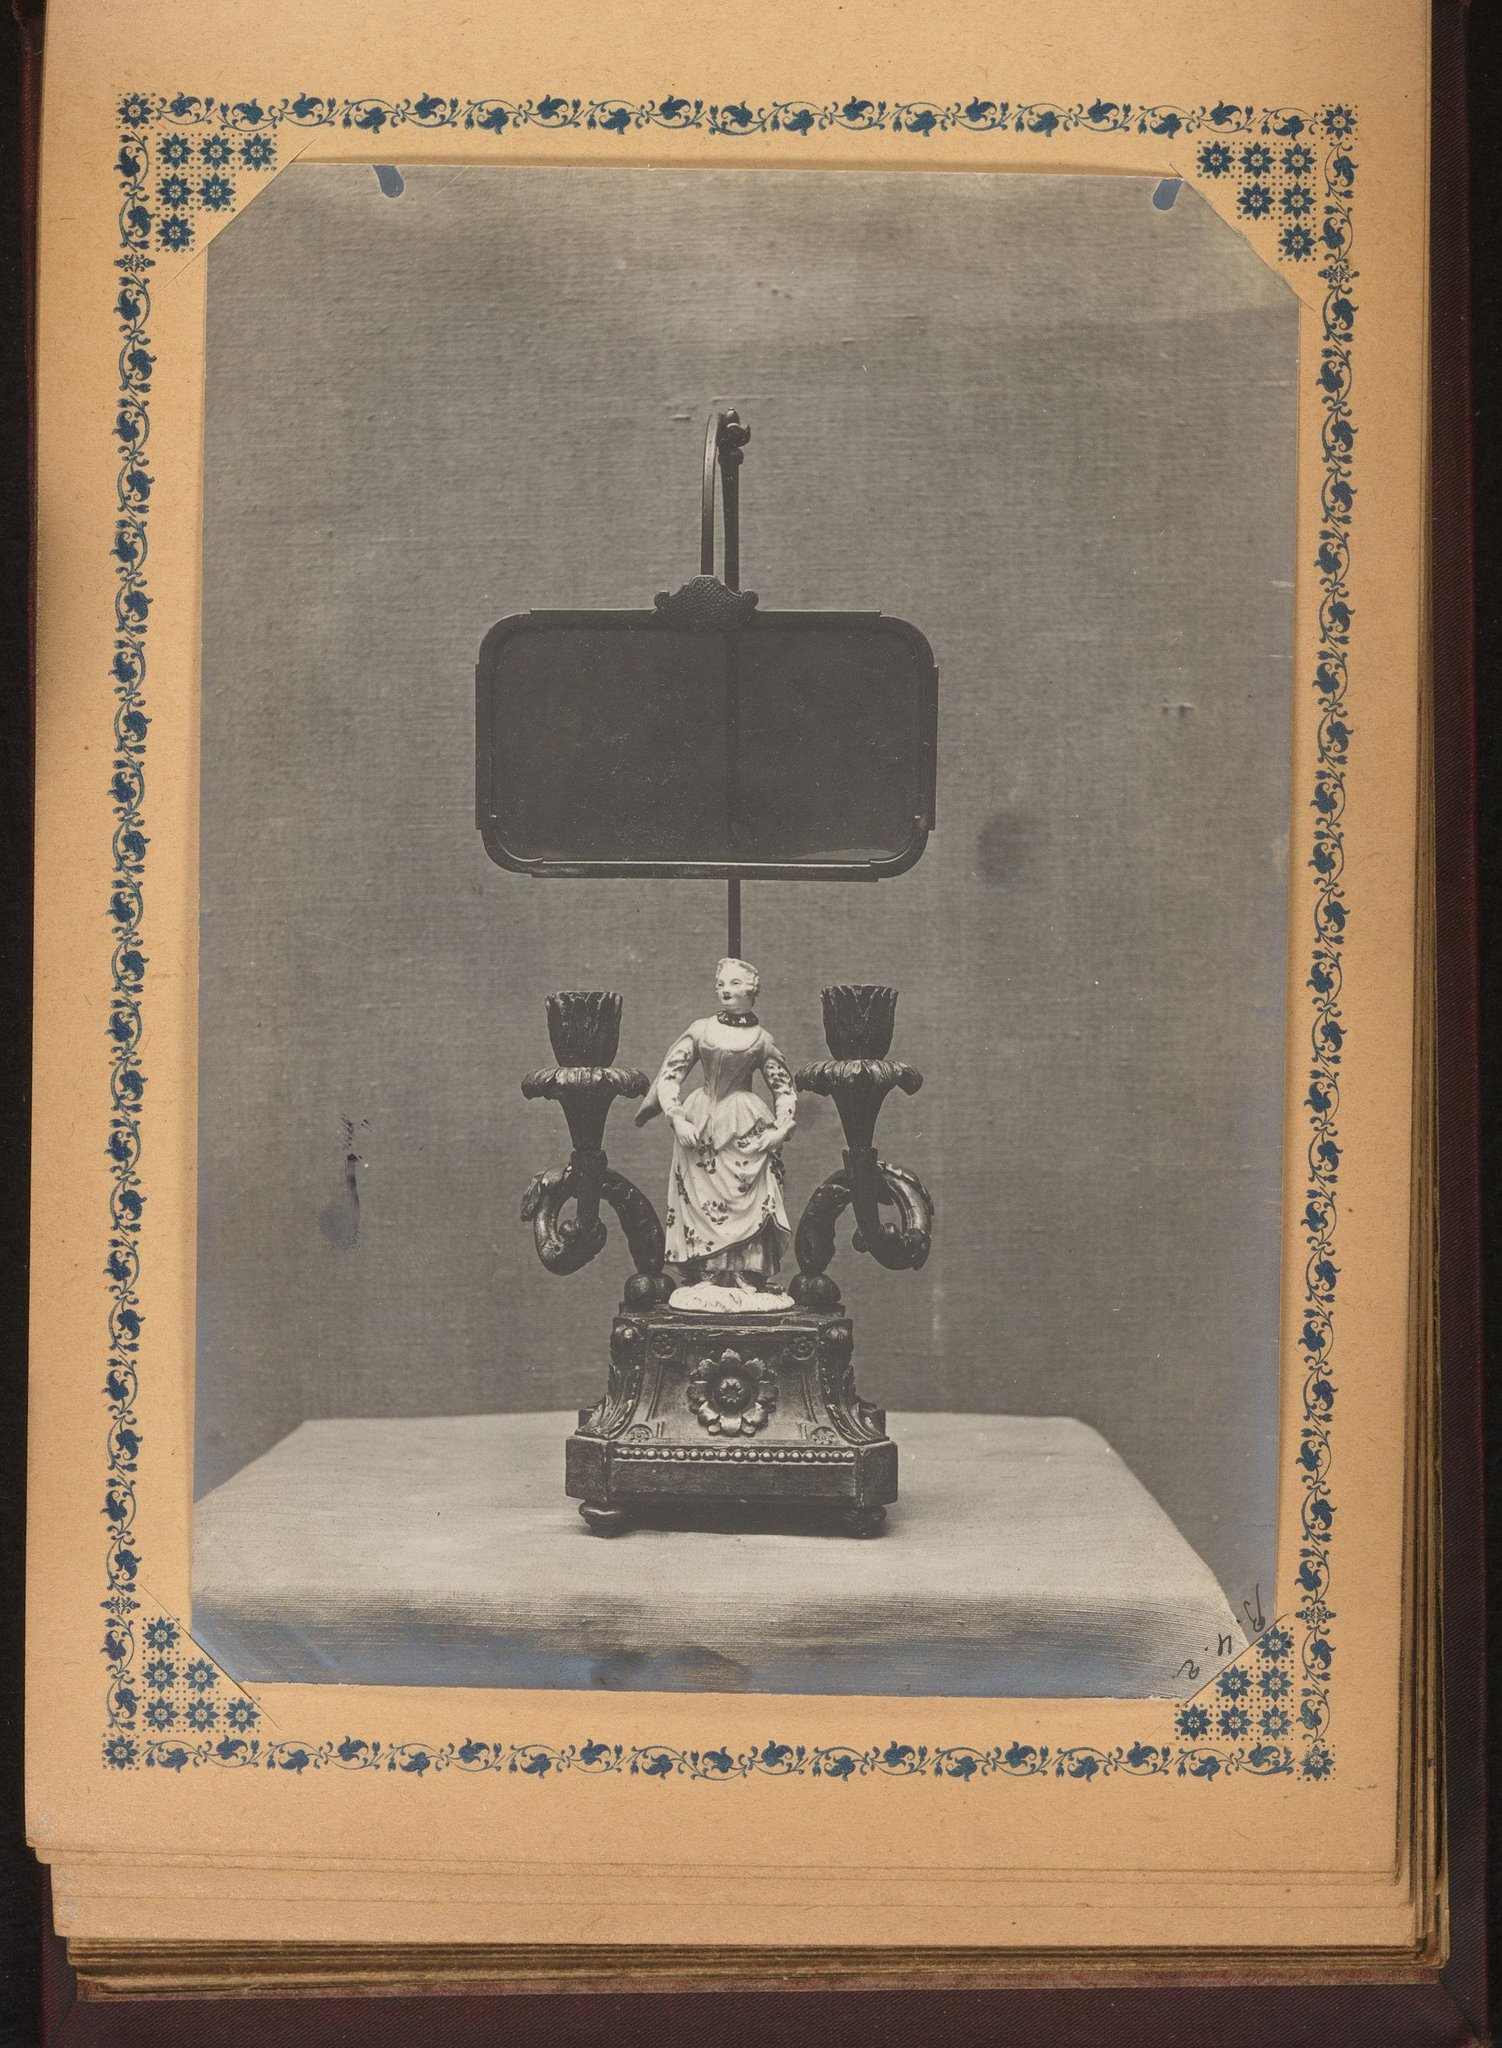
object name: album leaf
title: Kandelaar gedecoreerd met een sculptuur van een vrouw en twee bloemkelken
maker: Anonymous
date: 1880-1940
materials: cardboard, photographic support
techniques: gelatin silver print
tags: flowers, candlestick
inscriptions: number: ‘B. 4. 2.’